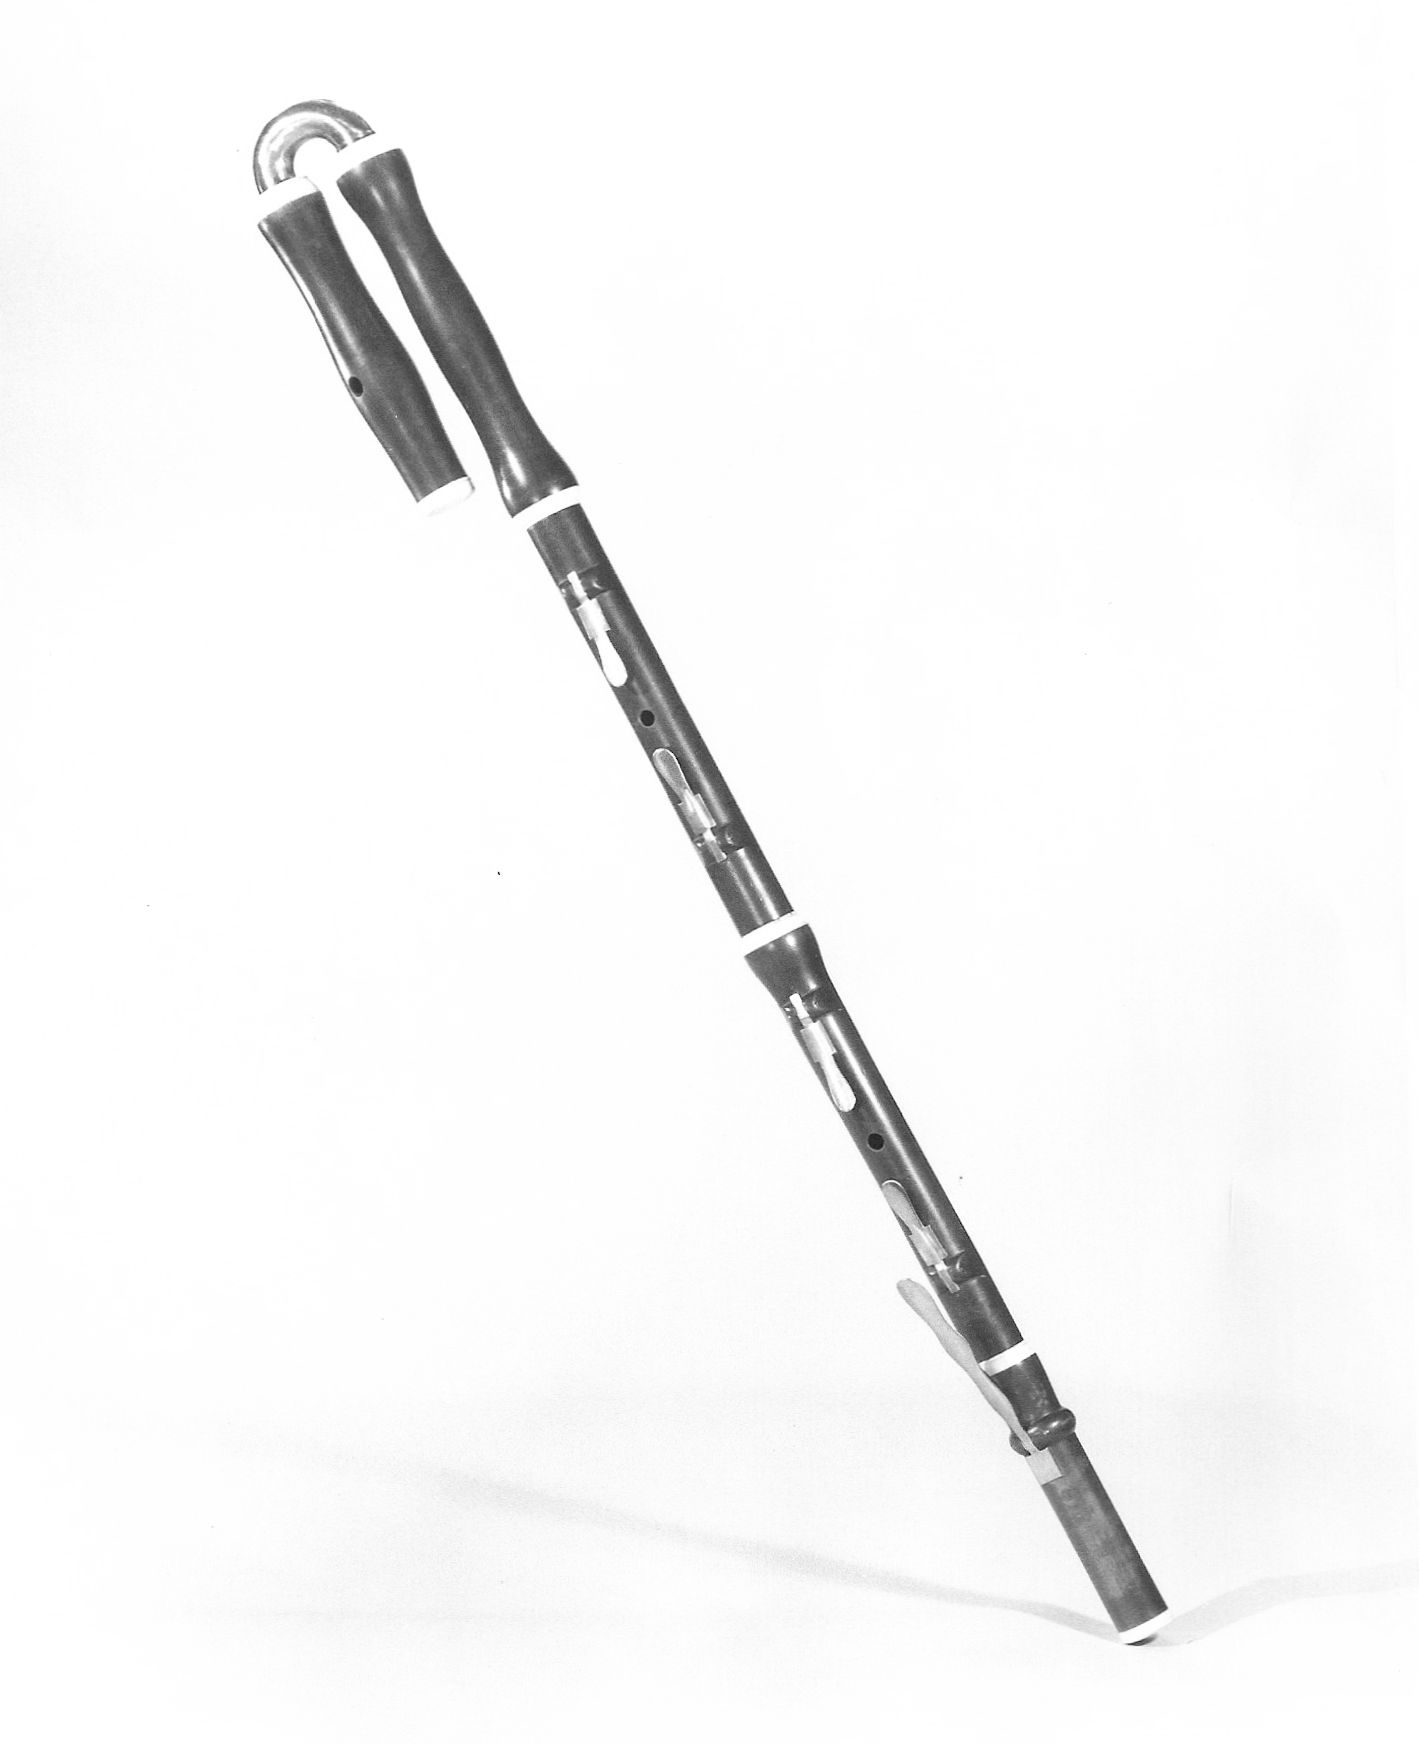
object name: transverse flute in c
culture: french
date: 1701-1800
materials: brass, ivory, wood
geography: france